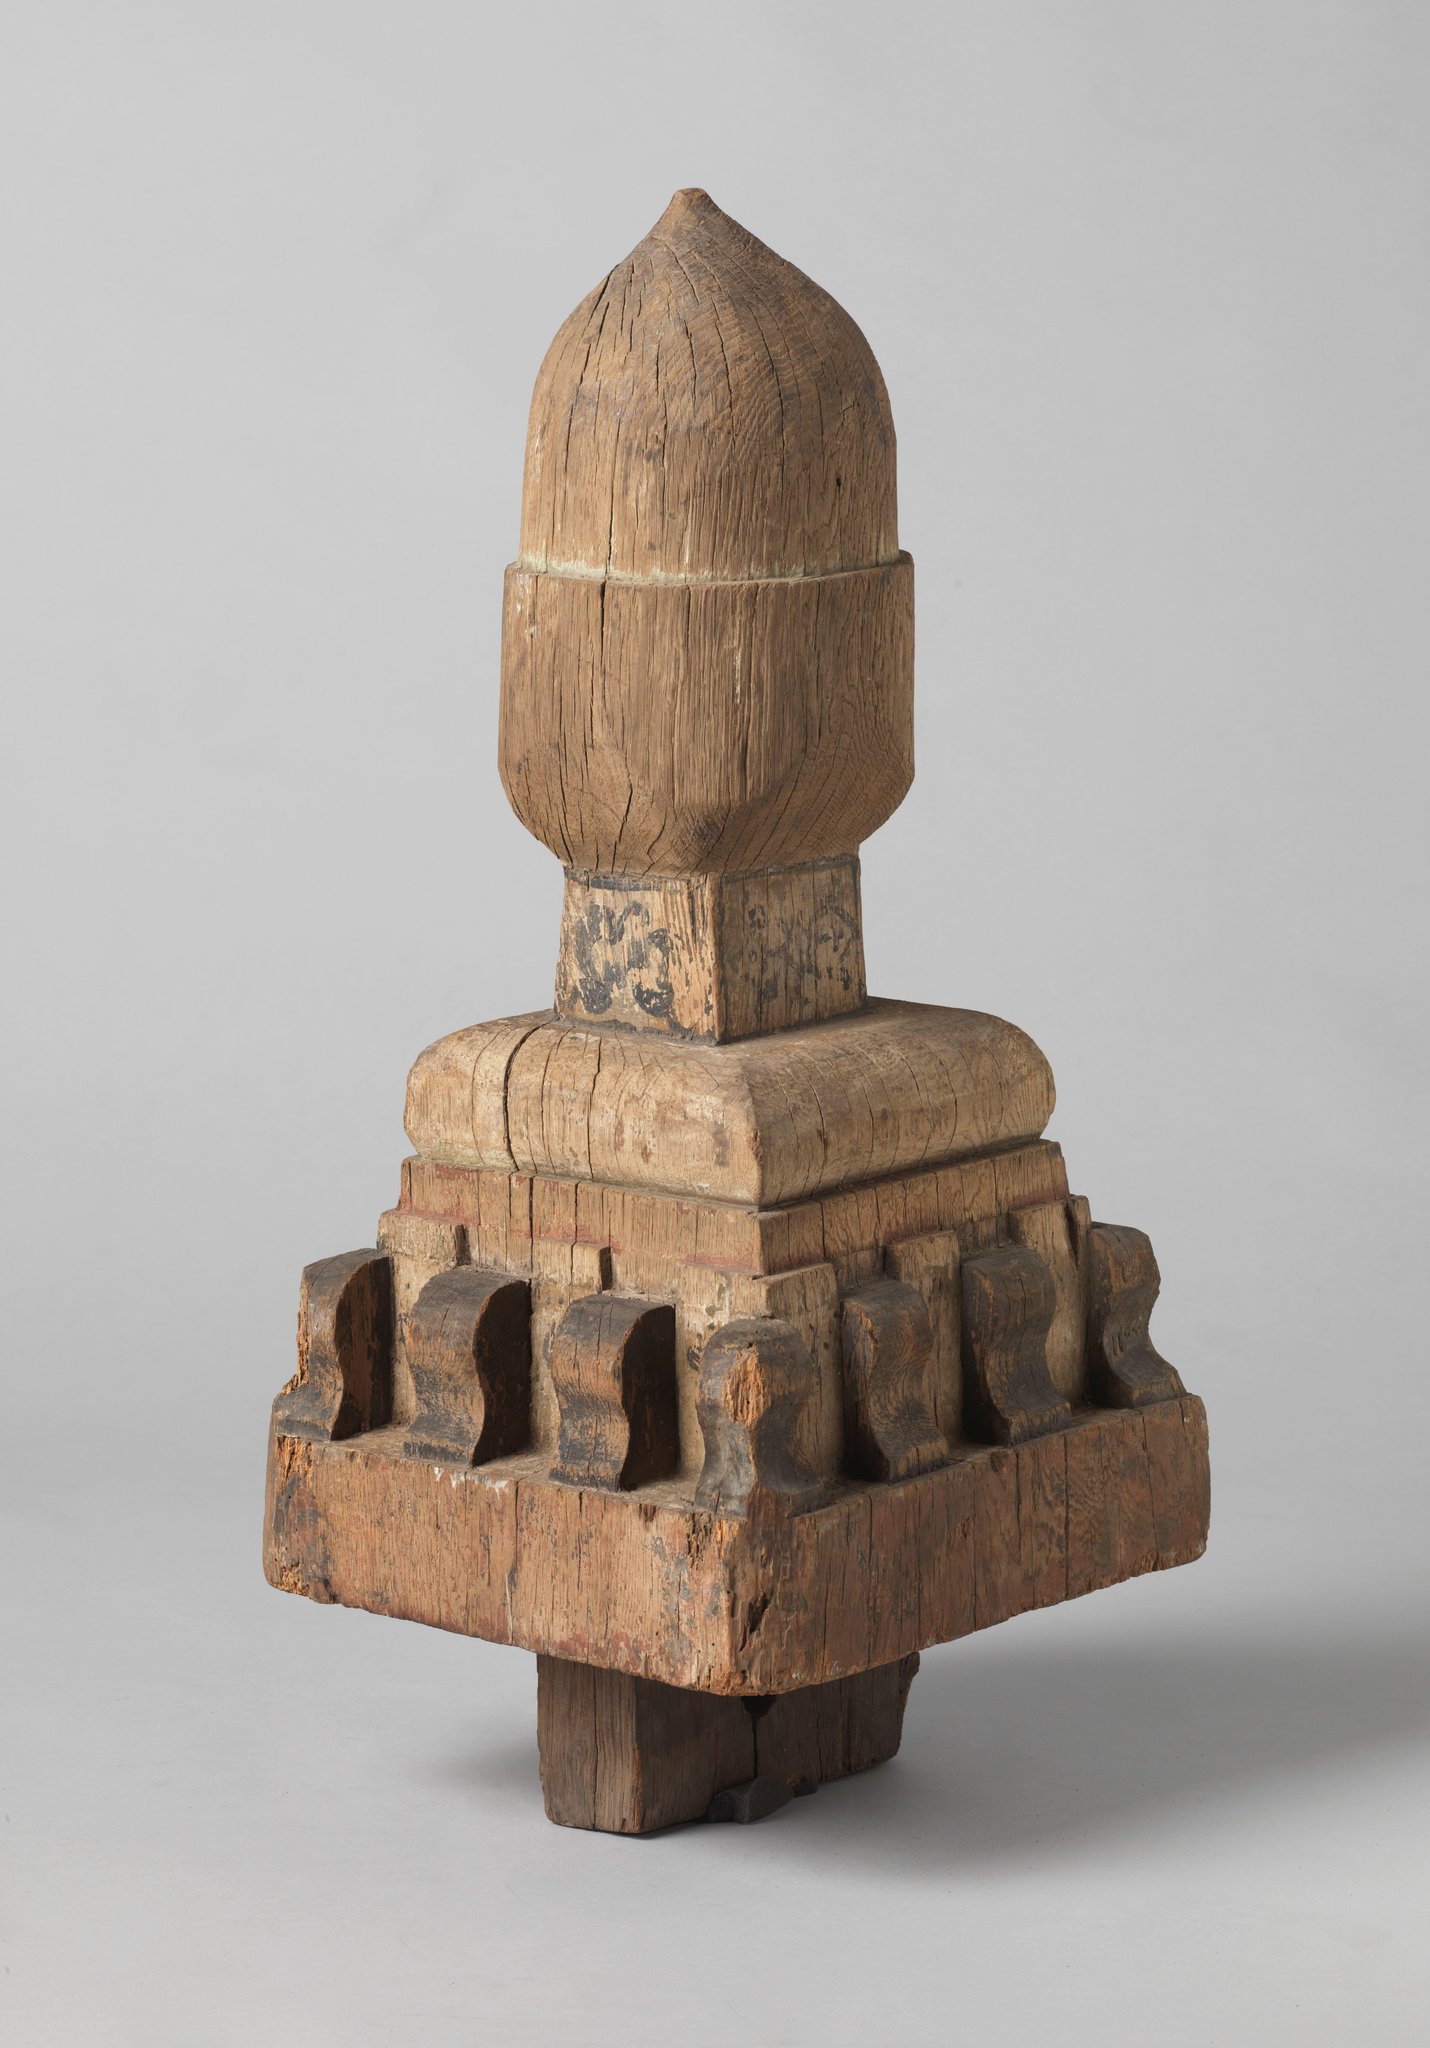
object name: fragment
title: Druiper van hout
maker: Anonymous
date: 1600-1699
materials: wood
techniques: painted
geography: northern netherlands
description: Houten druiper in kroonlijstvorm met tandlijst, uitlopende in een eikel. De sporen van beschildering met arabesken zijn nog aanwezig. Mogelijk een meubelfragment.